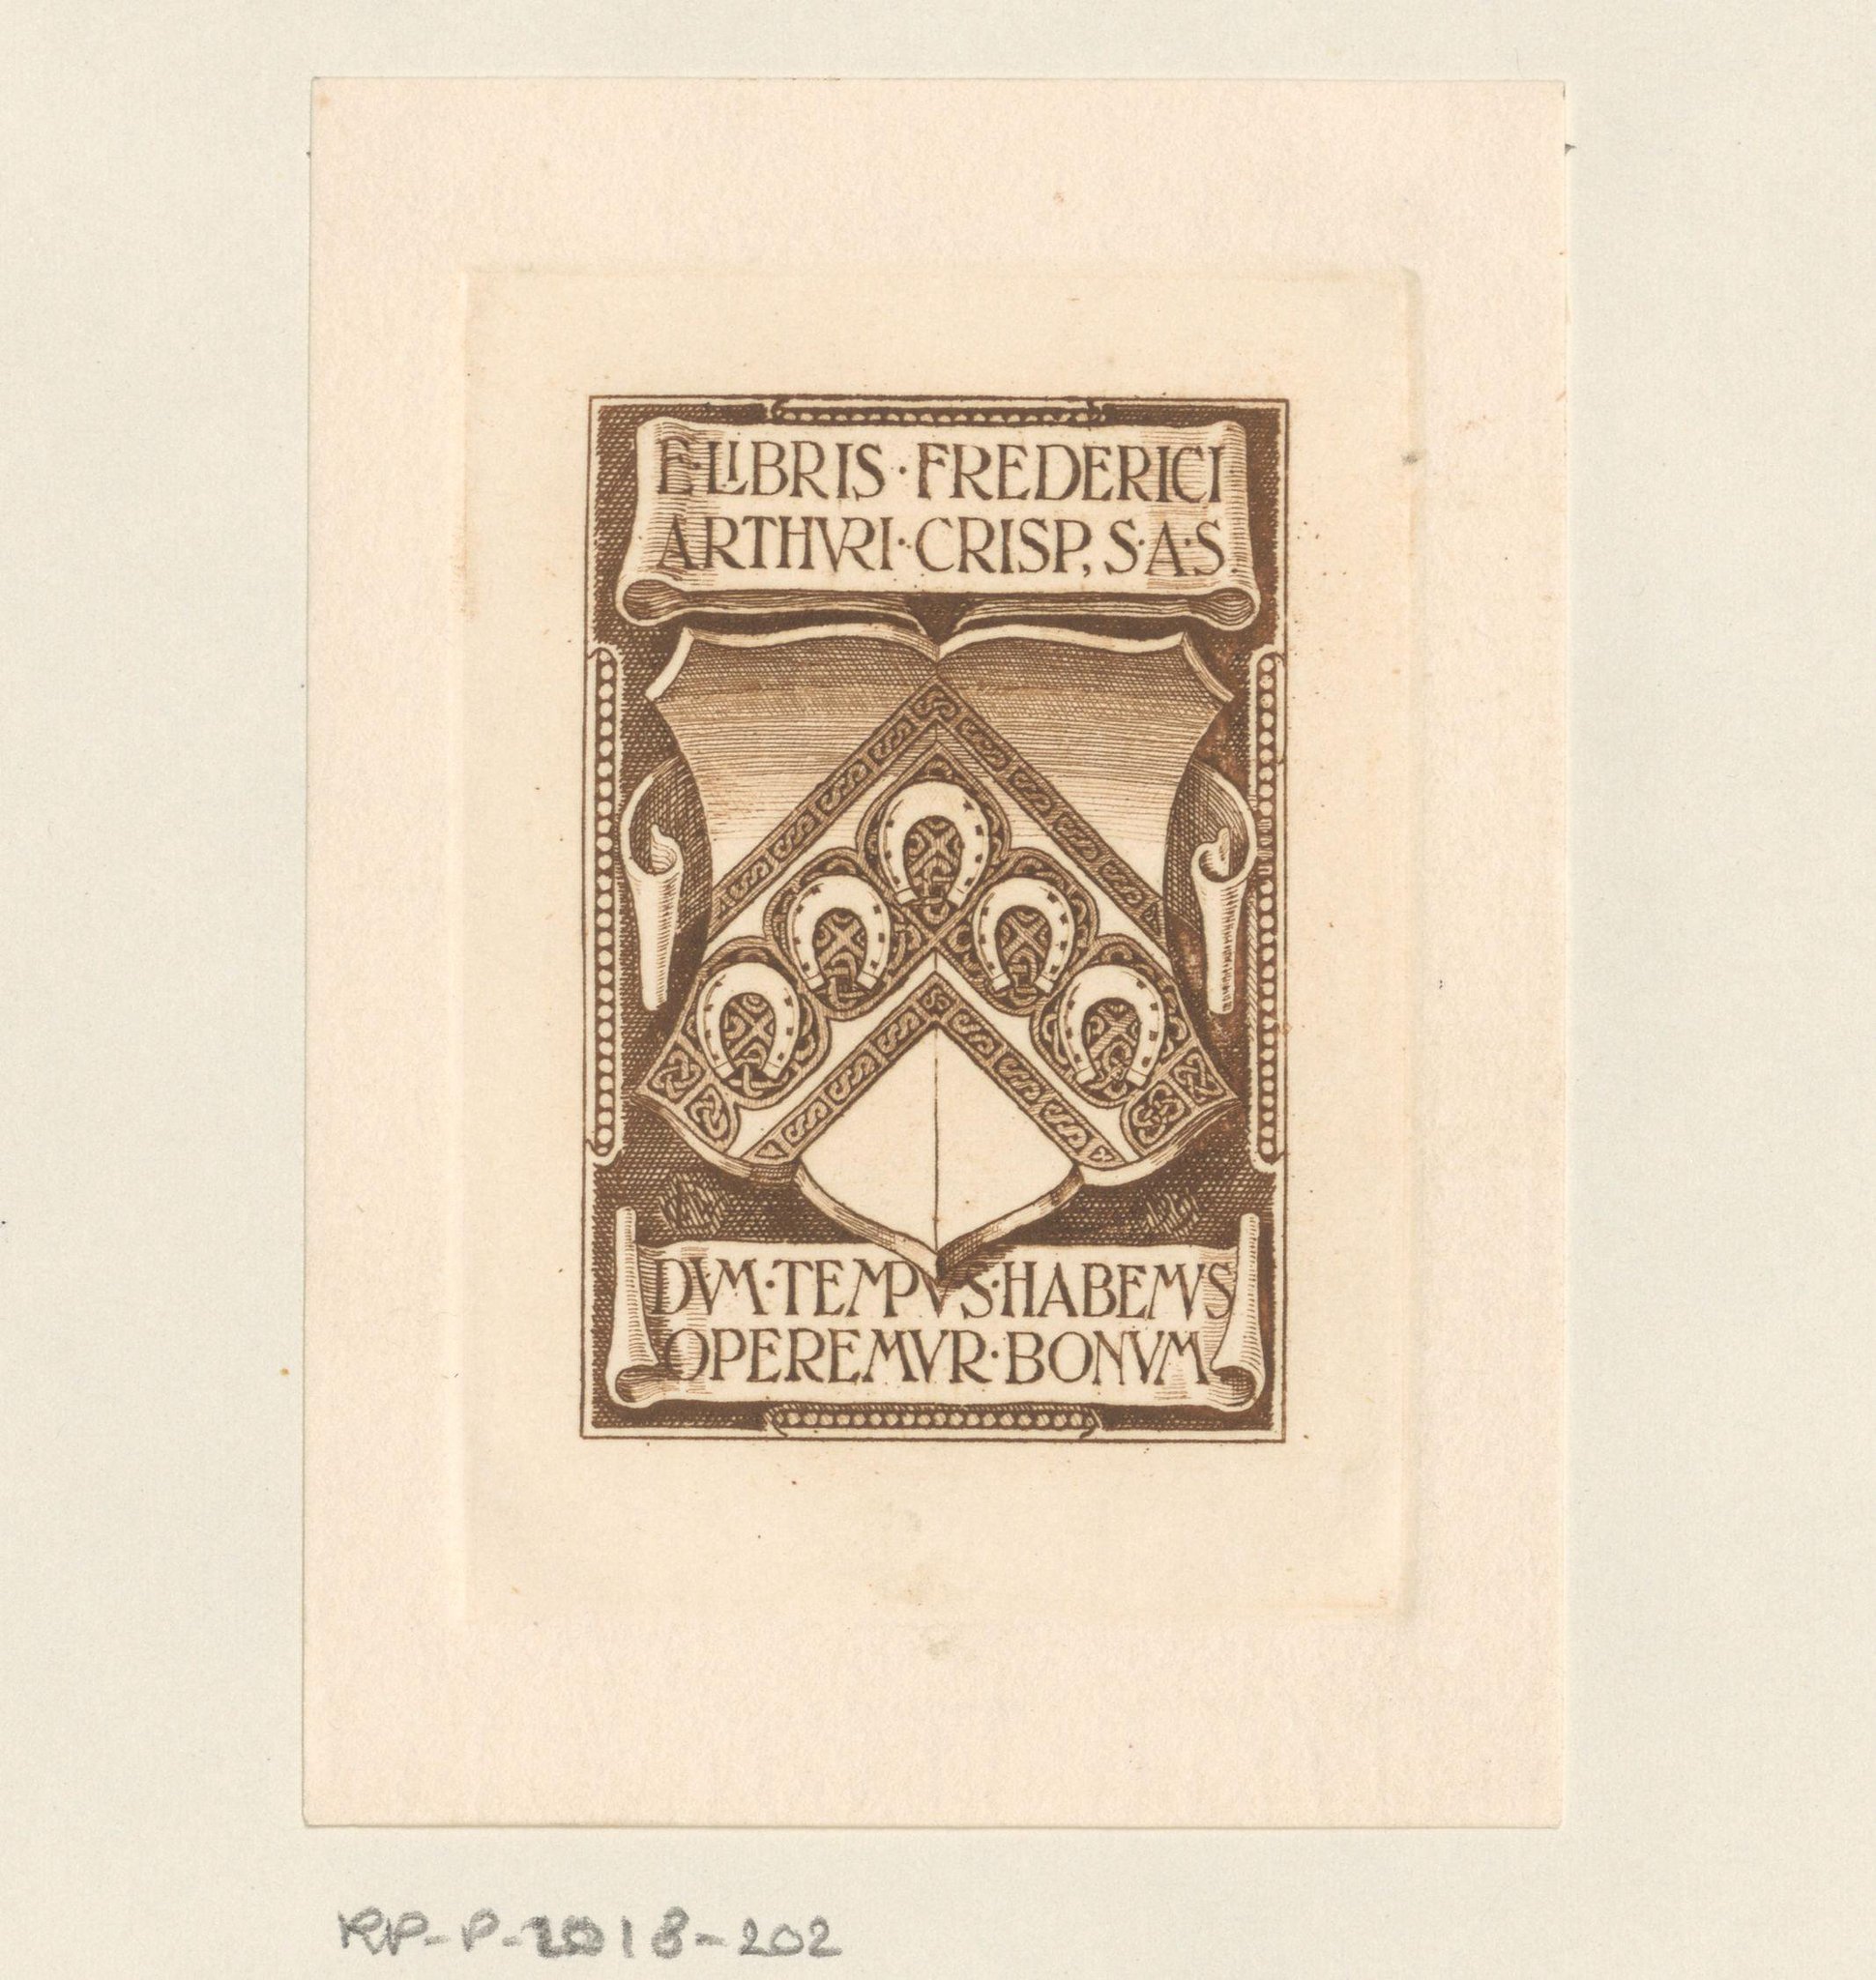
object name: bookplate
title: E. Libris Frederici Arthuri Crisp S.A.S.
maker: george william eve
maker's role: print maker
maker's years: 1855-1914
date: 1899-1999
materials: paper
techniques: etching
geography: england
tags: horseshoe, armorial bearing, heraldry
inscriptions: date